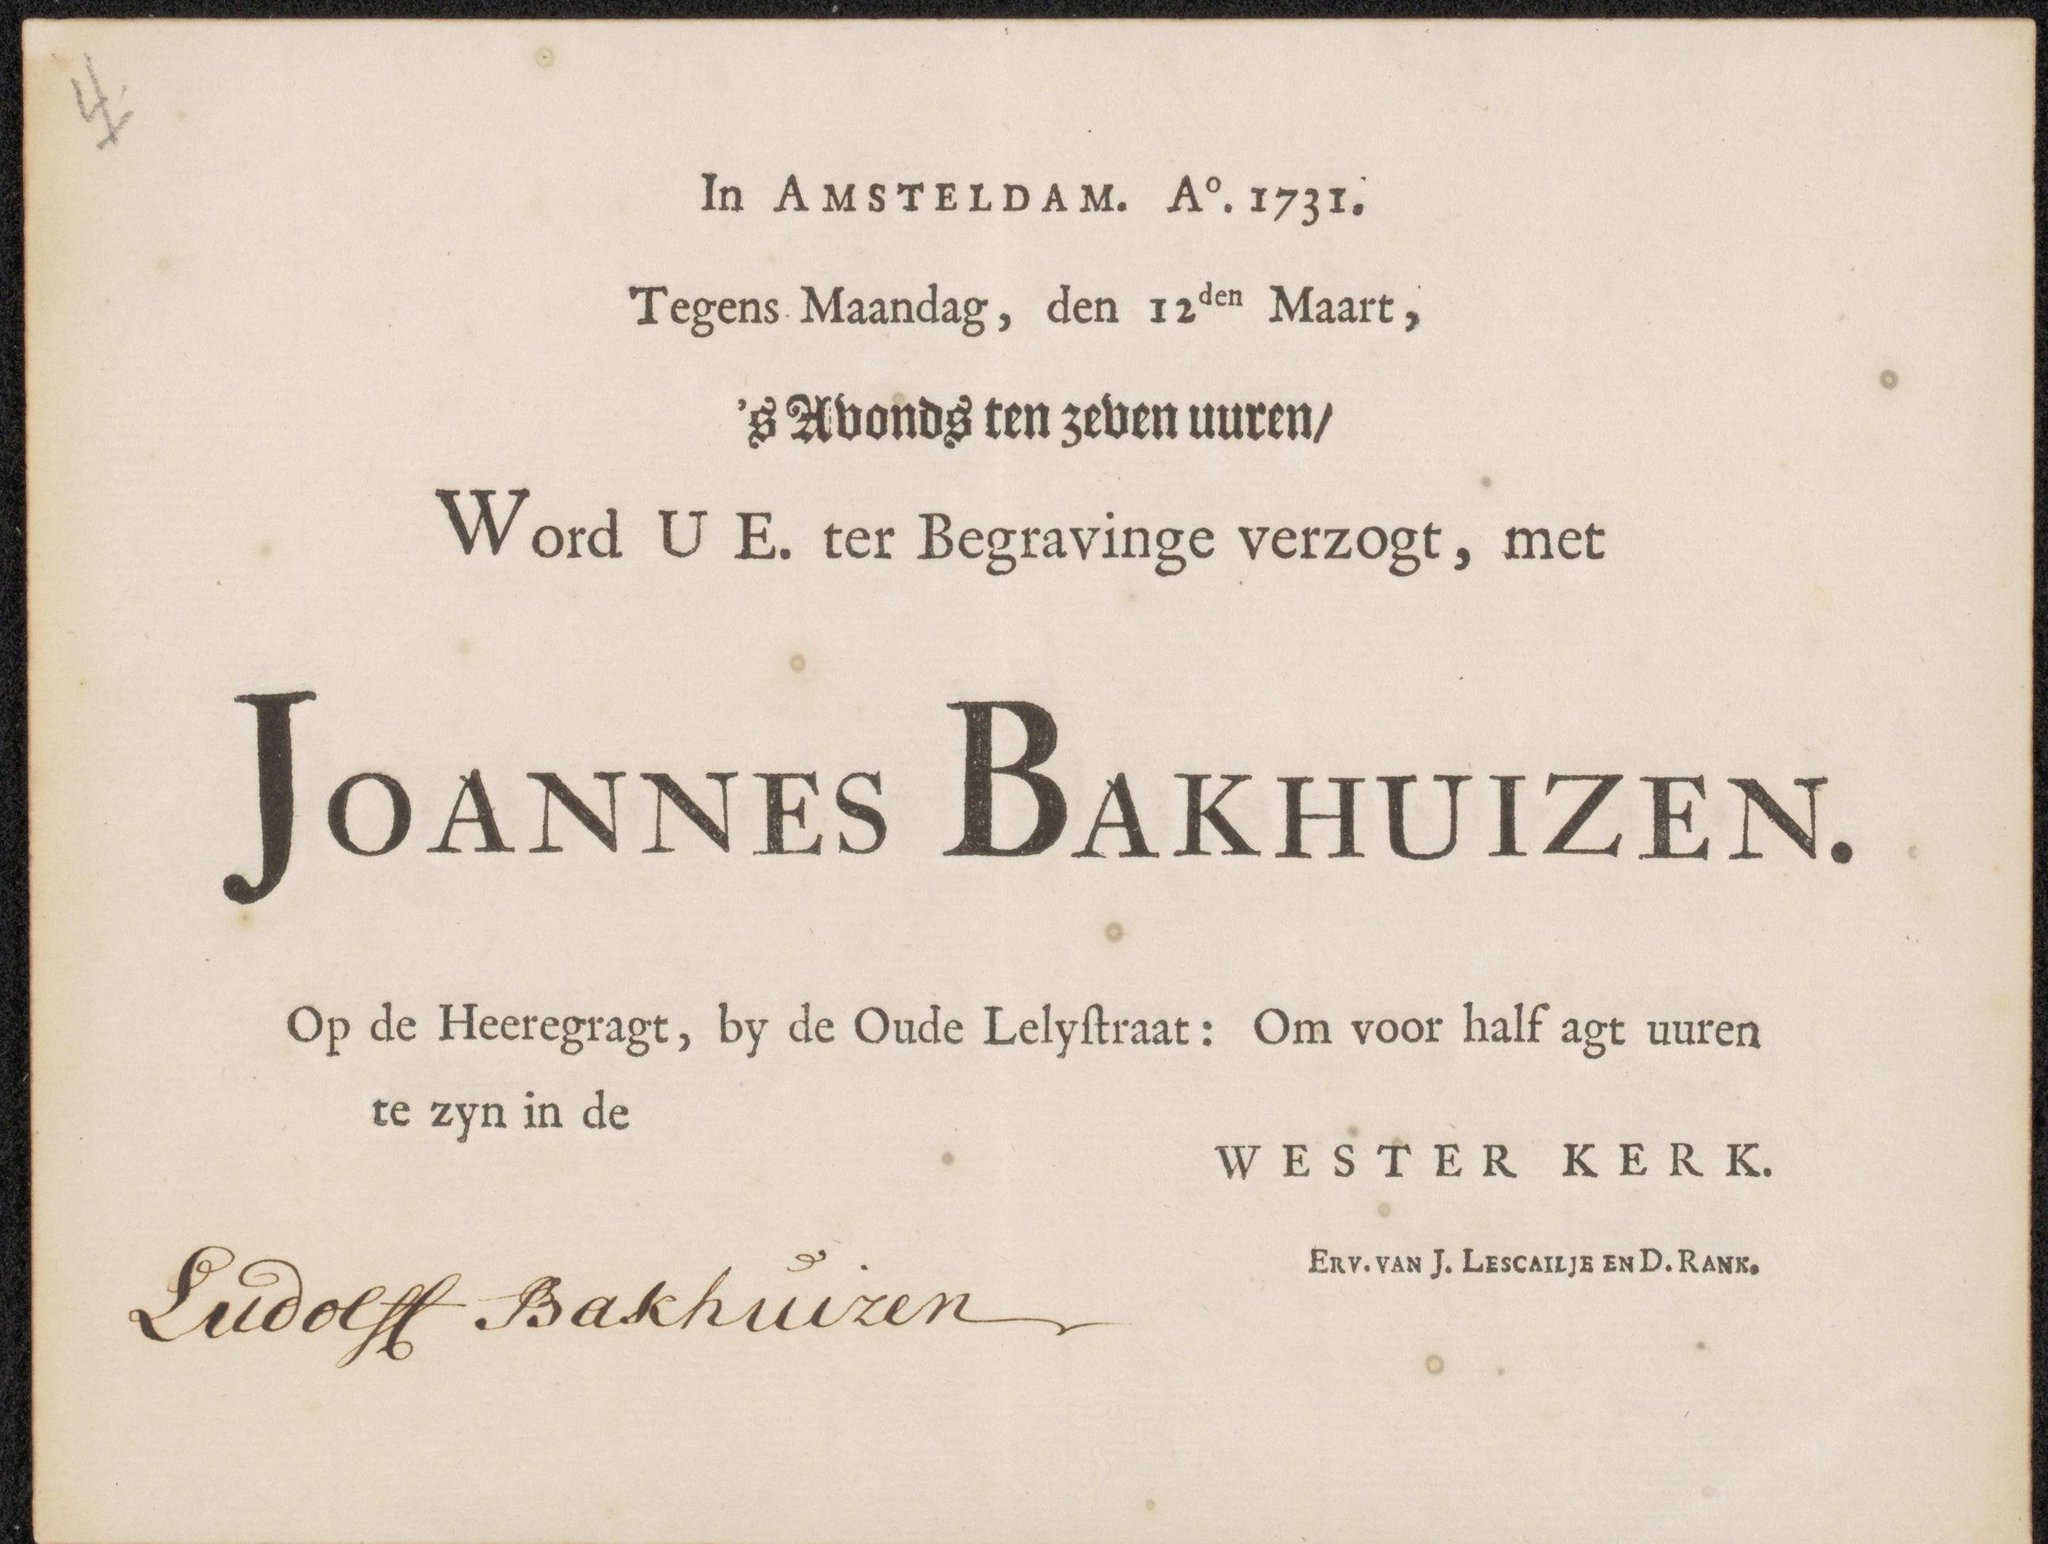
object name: invitation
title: Uitnodiging aan Ludolf Backhuysen (II)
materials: paper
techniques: printing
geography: amsterdam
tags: amsterdam, rotterdam, painter, johannes bakhuysen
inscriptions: watermark, collector's mark: Lugt 2233